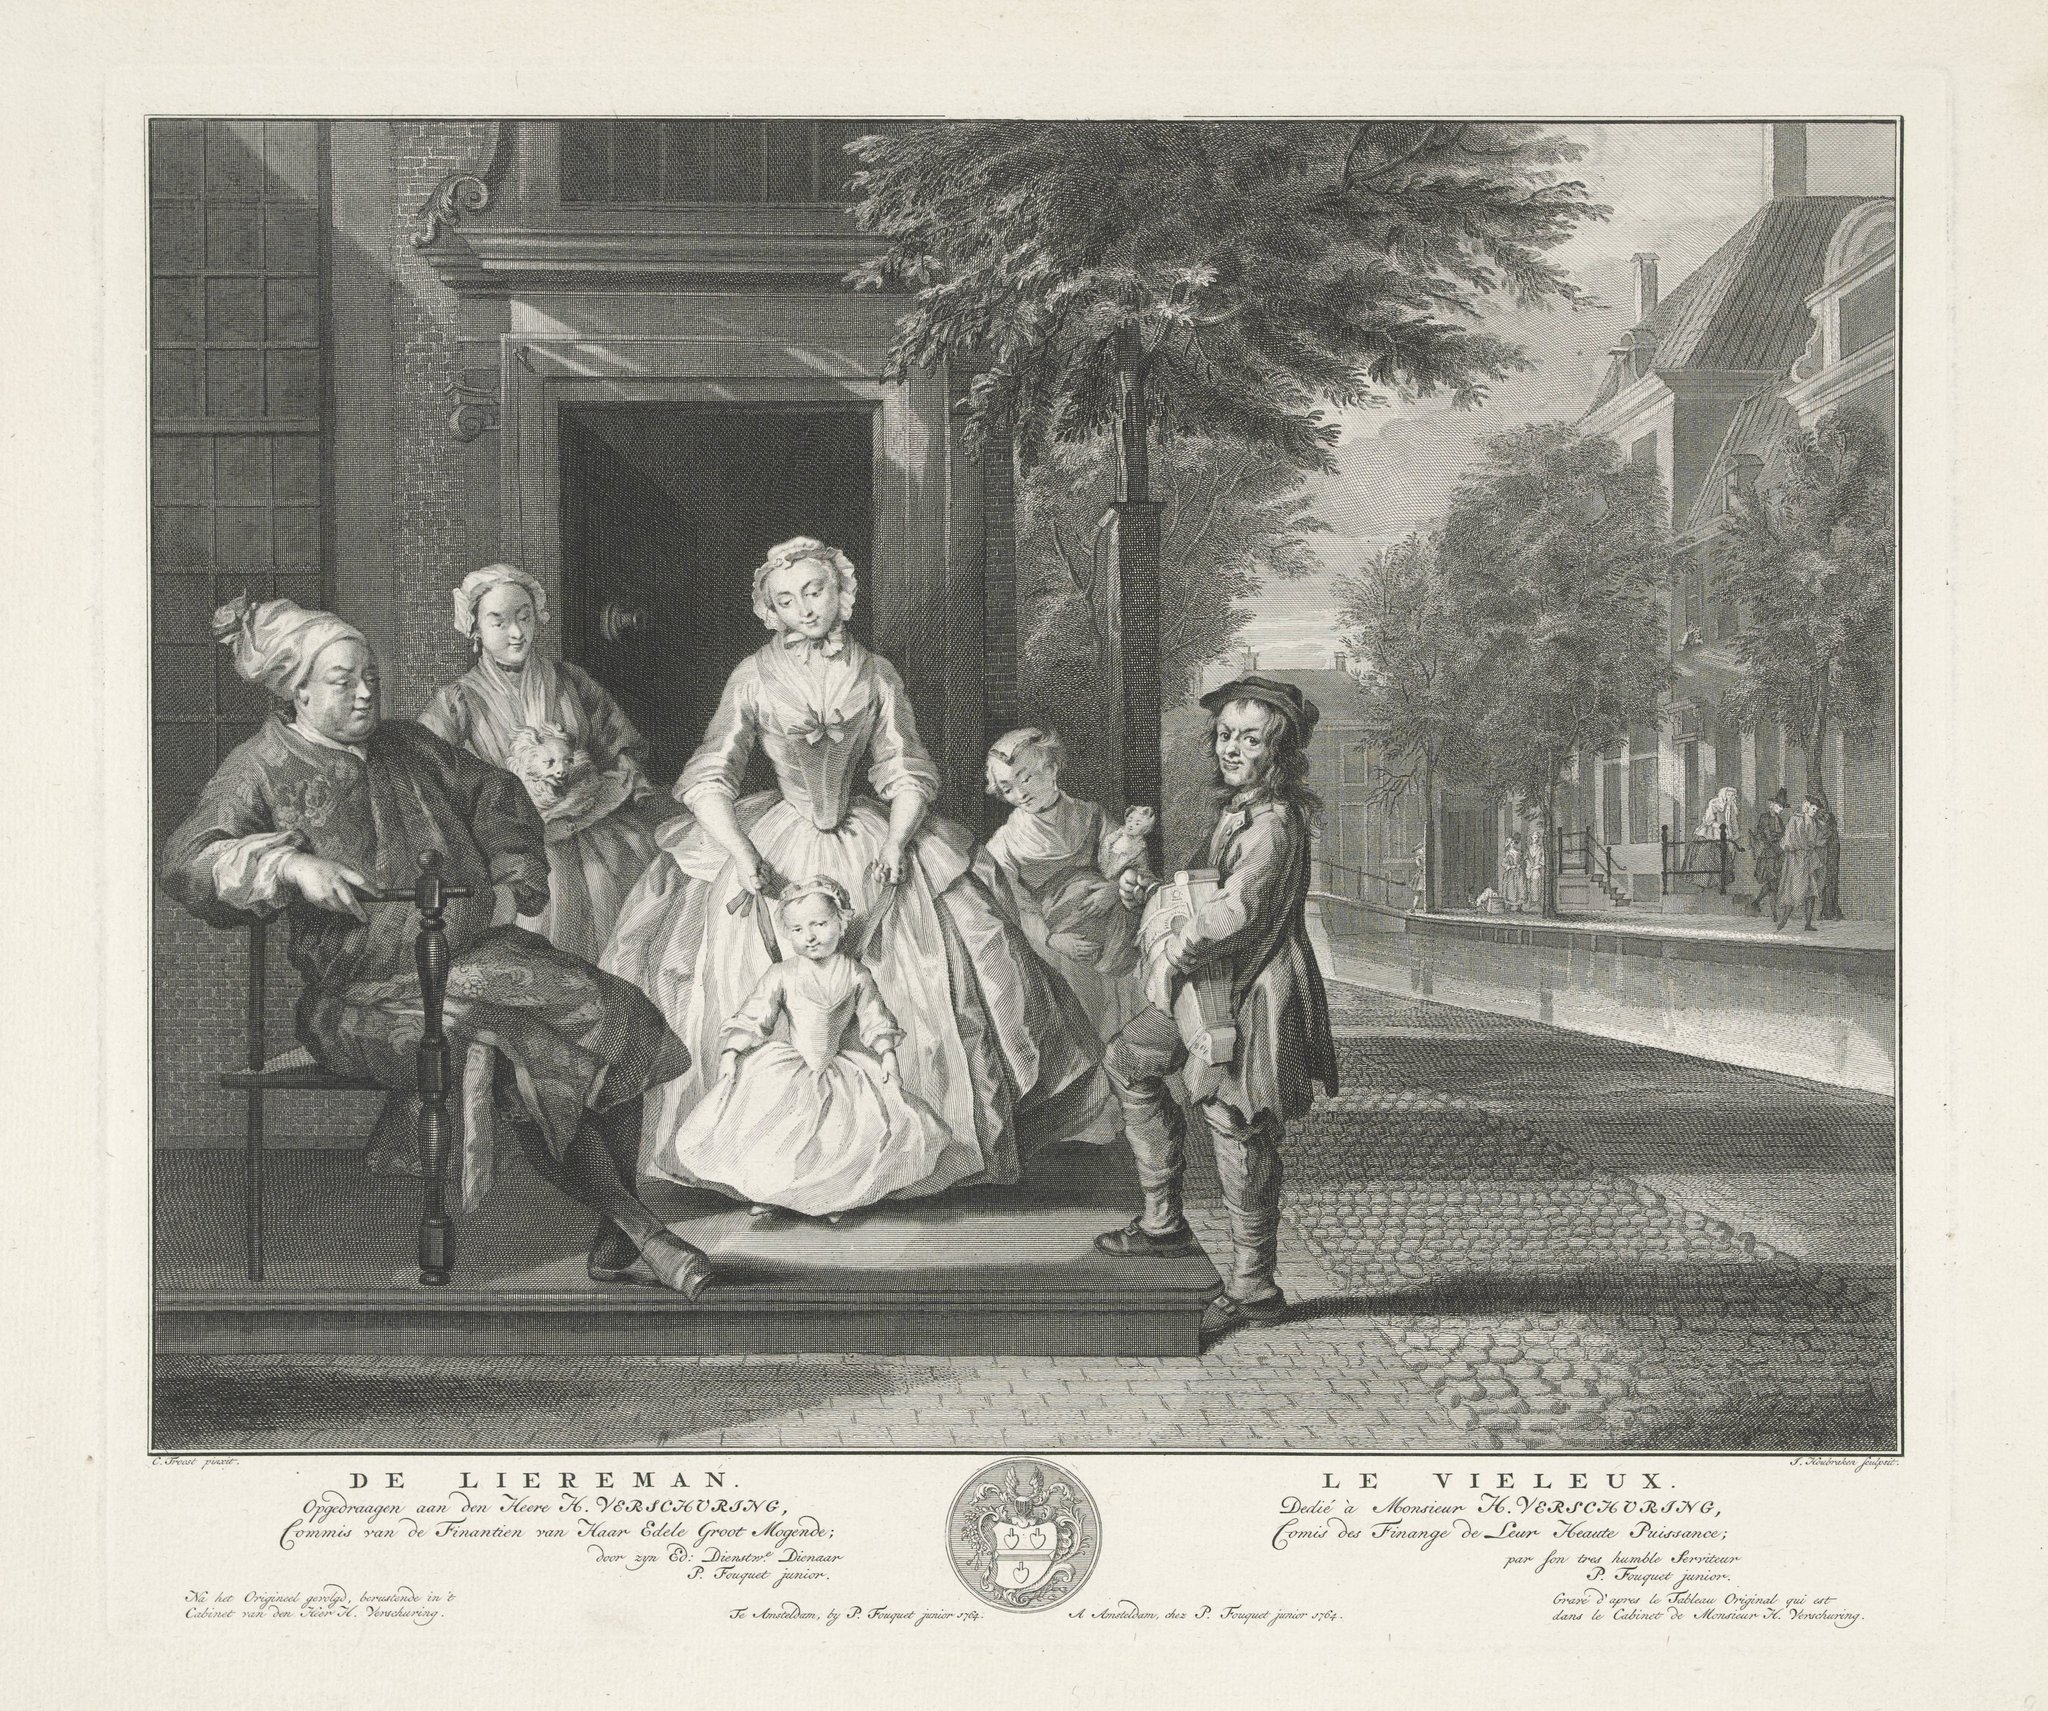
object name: print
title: De liereman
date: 1762-1764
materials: paper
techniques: engraving, etching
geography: amsterdam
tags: parents with their children, hurdy-gurdy player - cc - out of doors, canals, waters (in city) (+ city(-scape) with figures, staffage)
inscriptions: collector's mark: Lugt 240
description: Op een stoep voor een deuropening in een stad zit een gezin waaronder twee jonge kinderen. Naast hen staat een straatmuzikant met een draailier. Rechts een gracht.